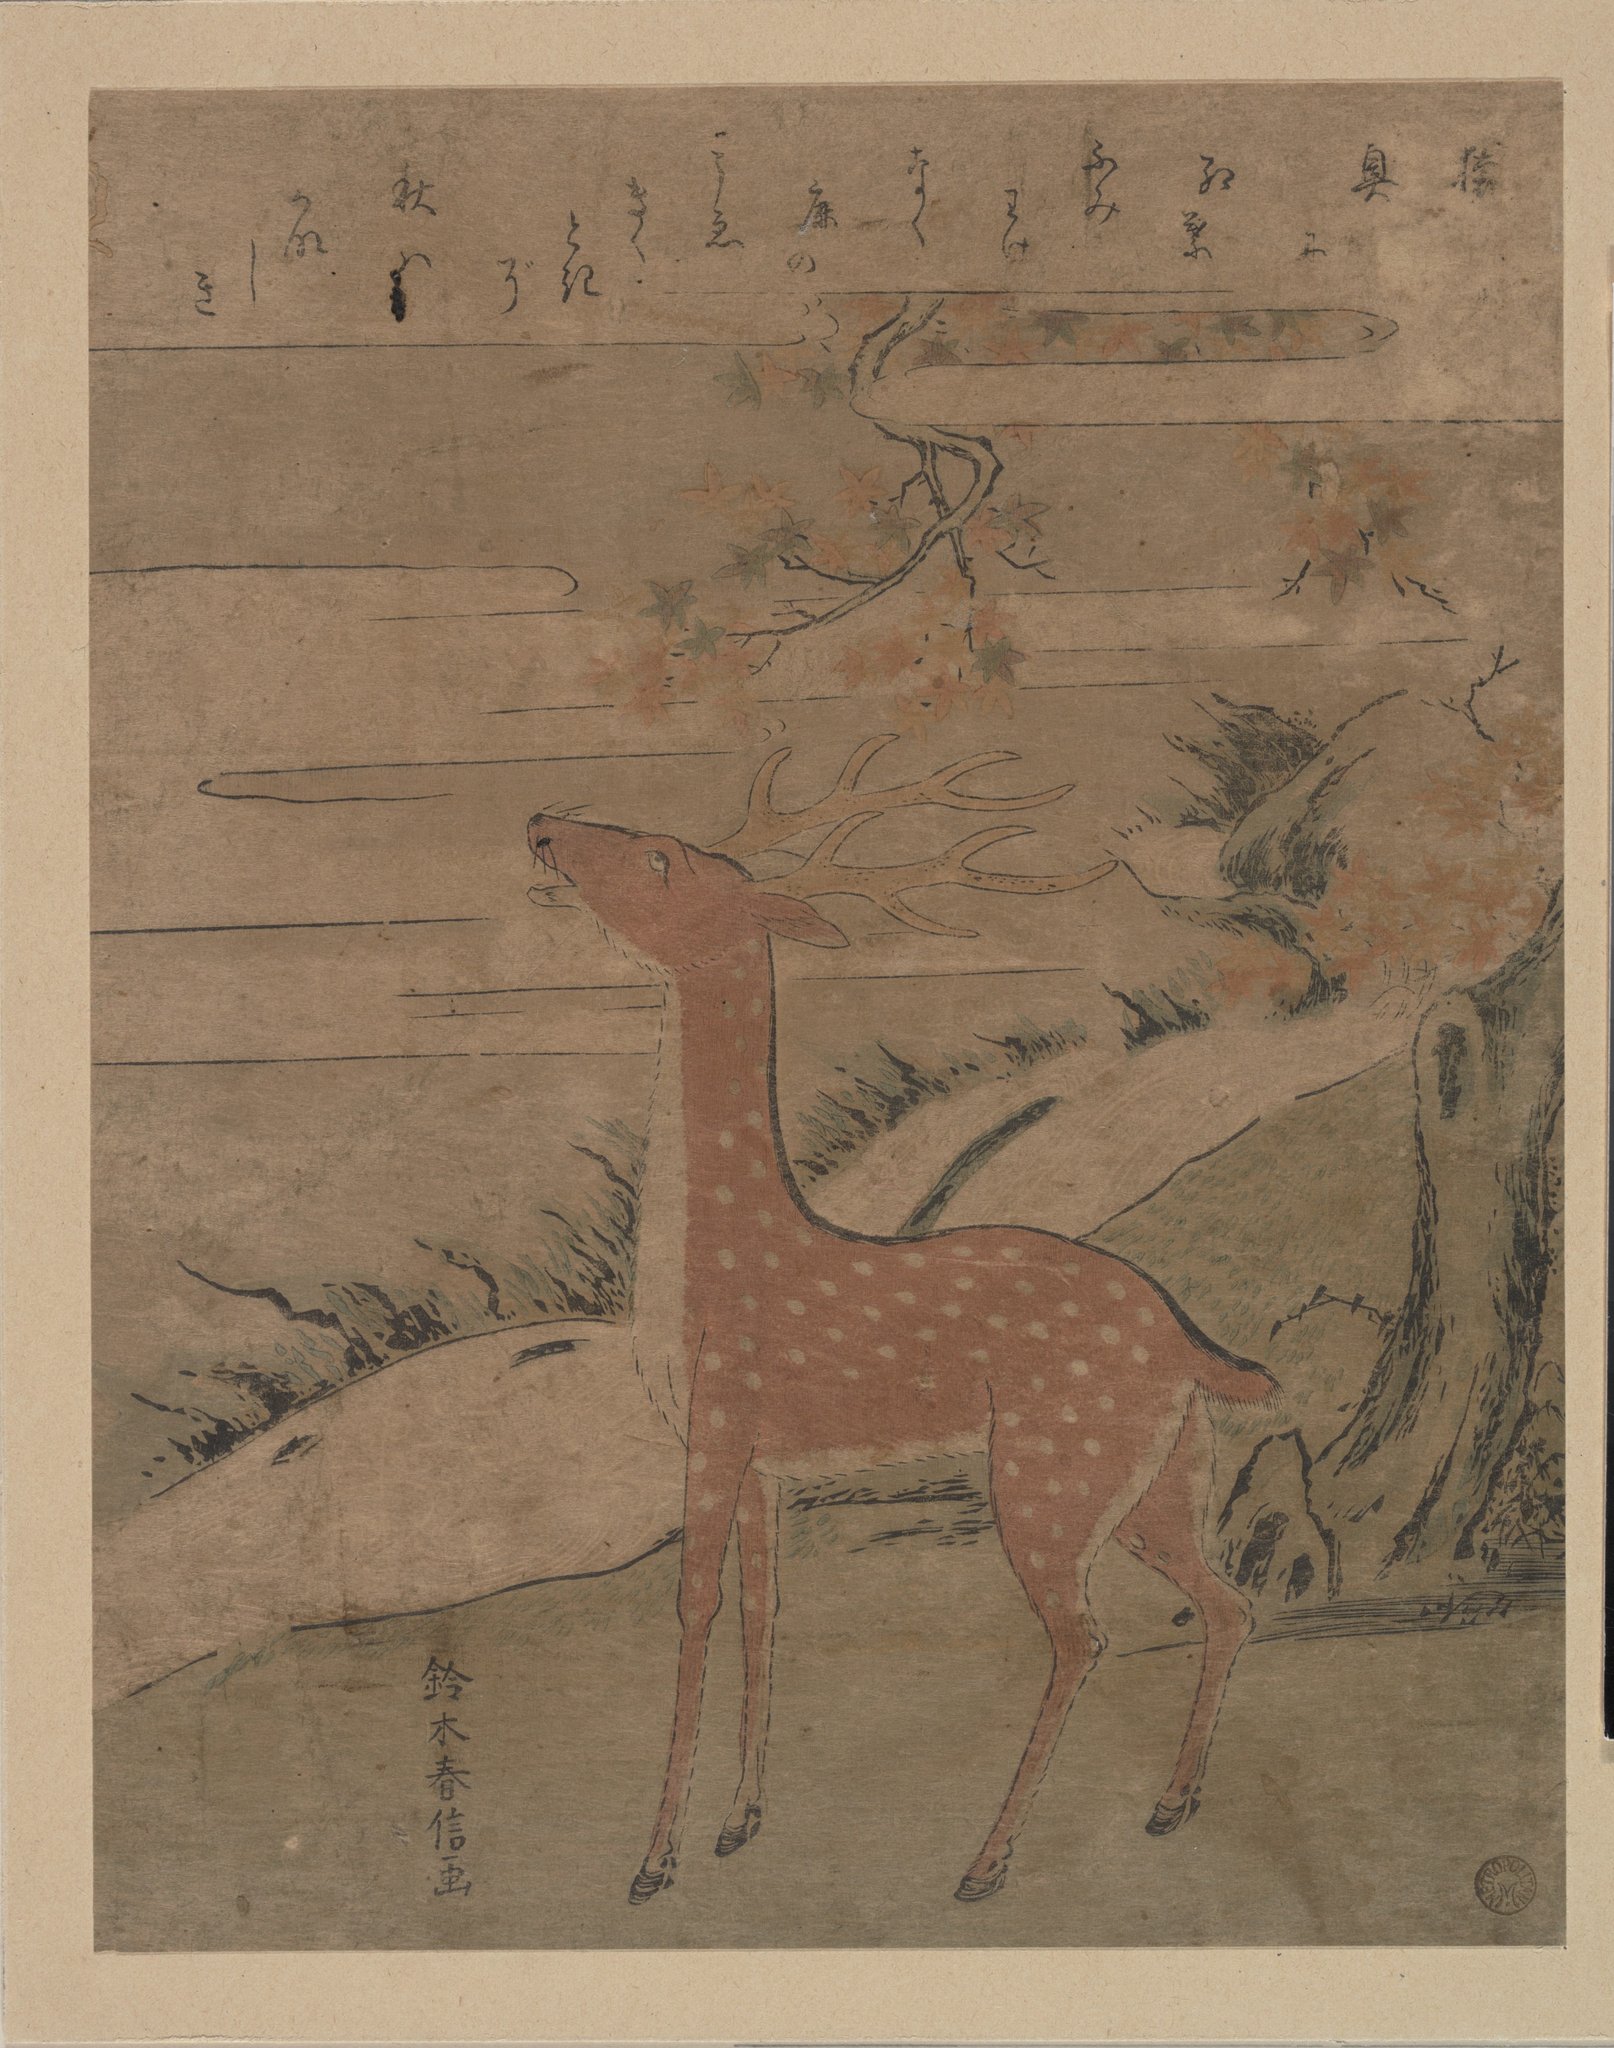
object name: print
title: The Cry of the Stag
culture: japanese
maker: suzuki harunobu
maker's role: artist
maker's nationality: japanese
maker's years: 1725-1770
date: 1760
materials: ink, paper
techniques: woodblock print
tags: deer